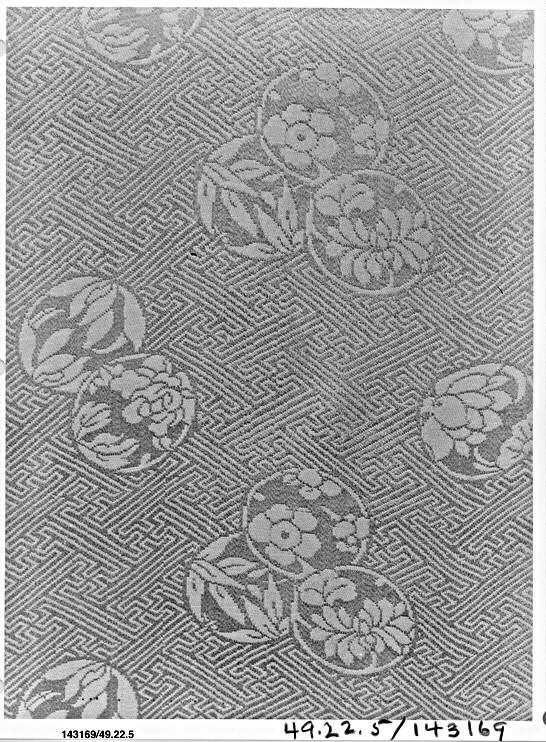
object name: piece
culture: chinese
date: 1901-2000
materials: silk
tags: flowers